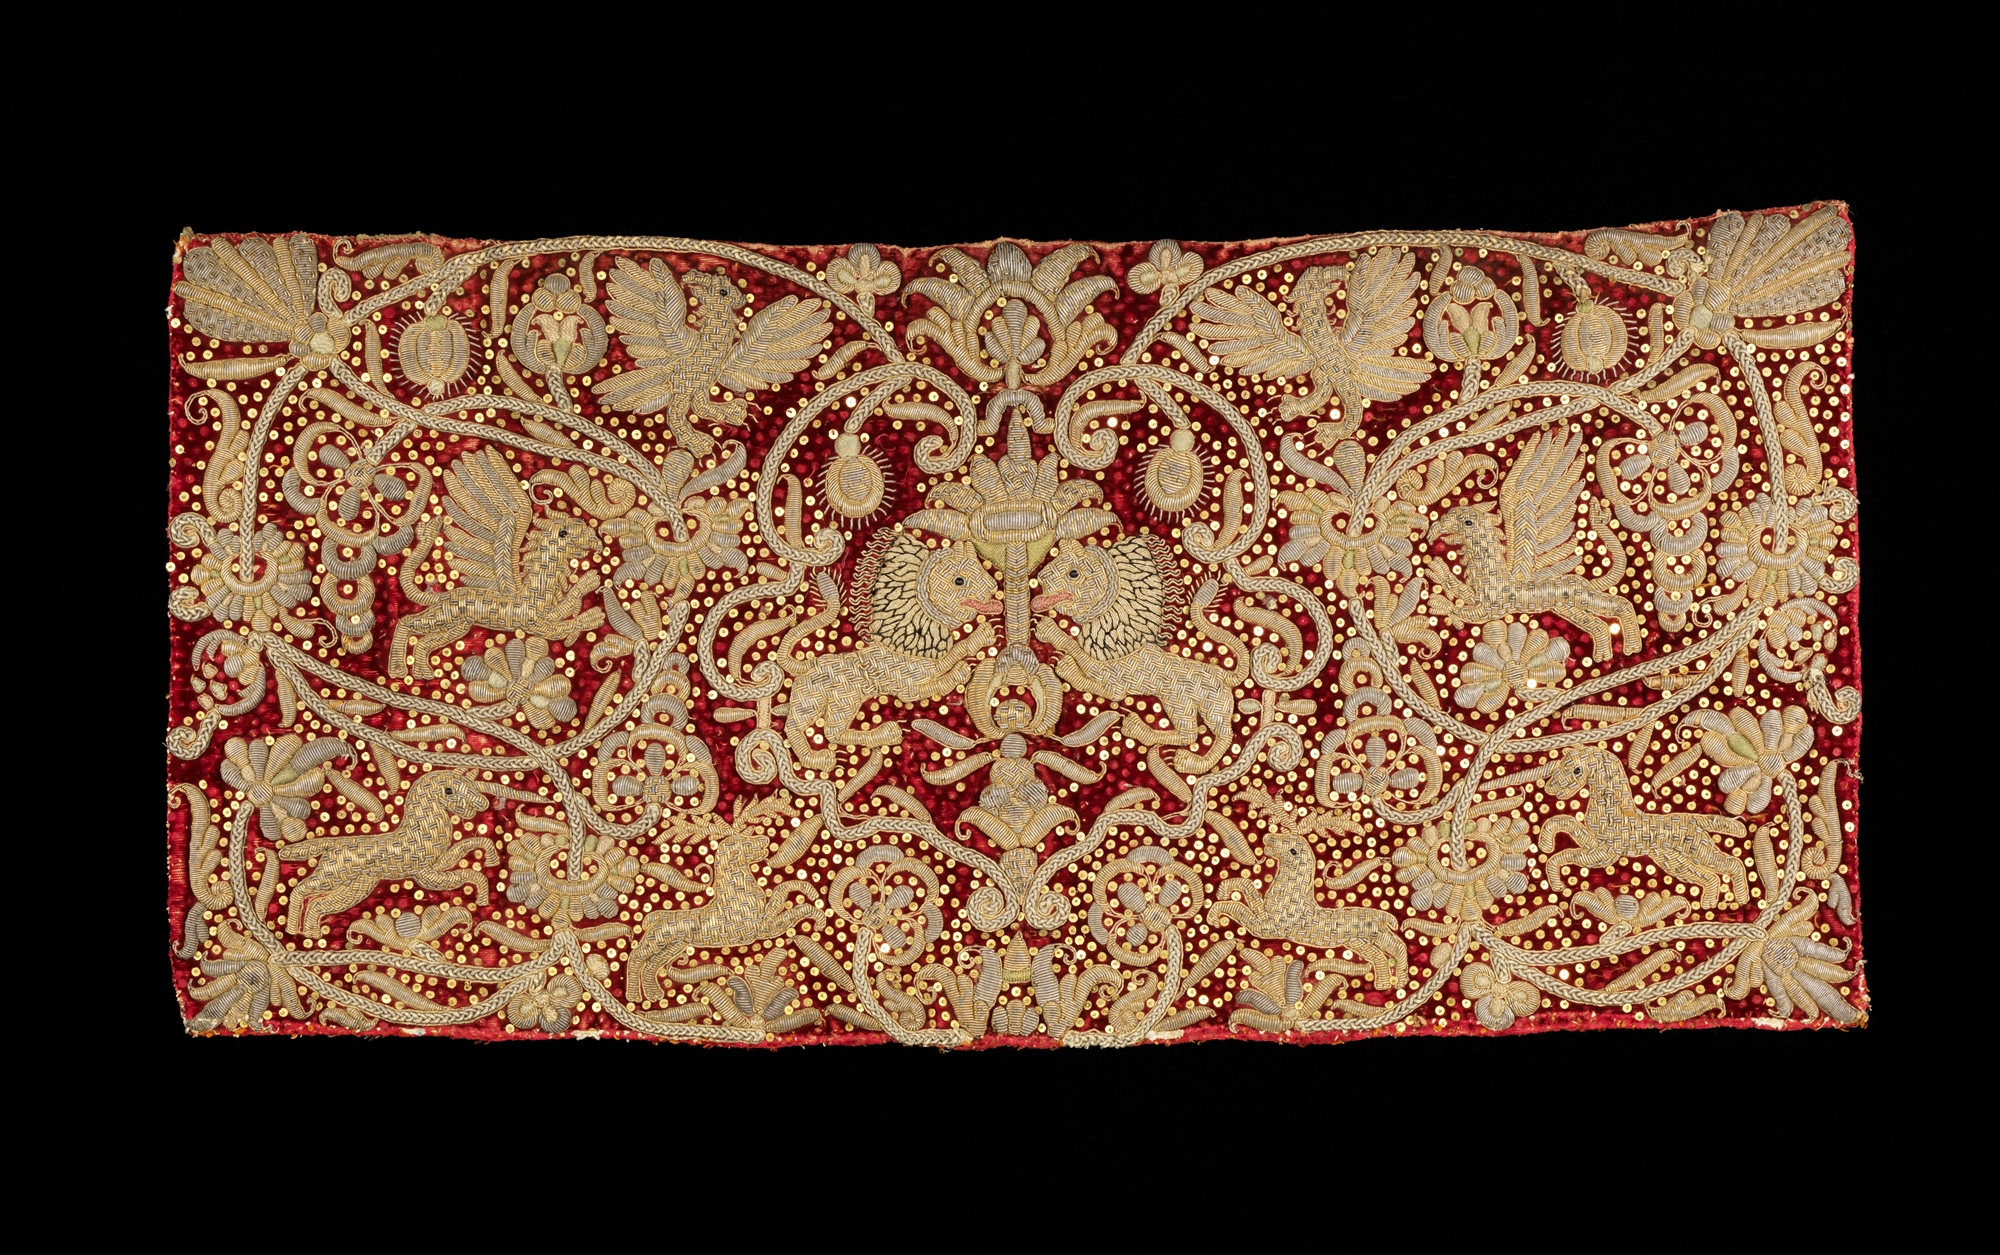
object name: vestment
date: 1675-1725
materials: metal, silk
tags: griffins,deer,horses,lions